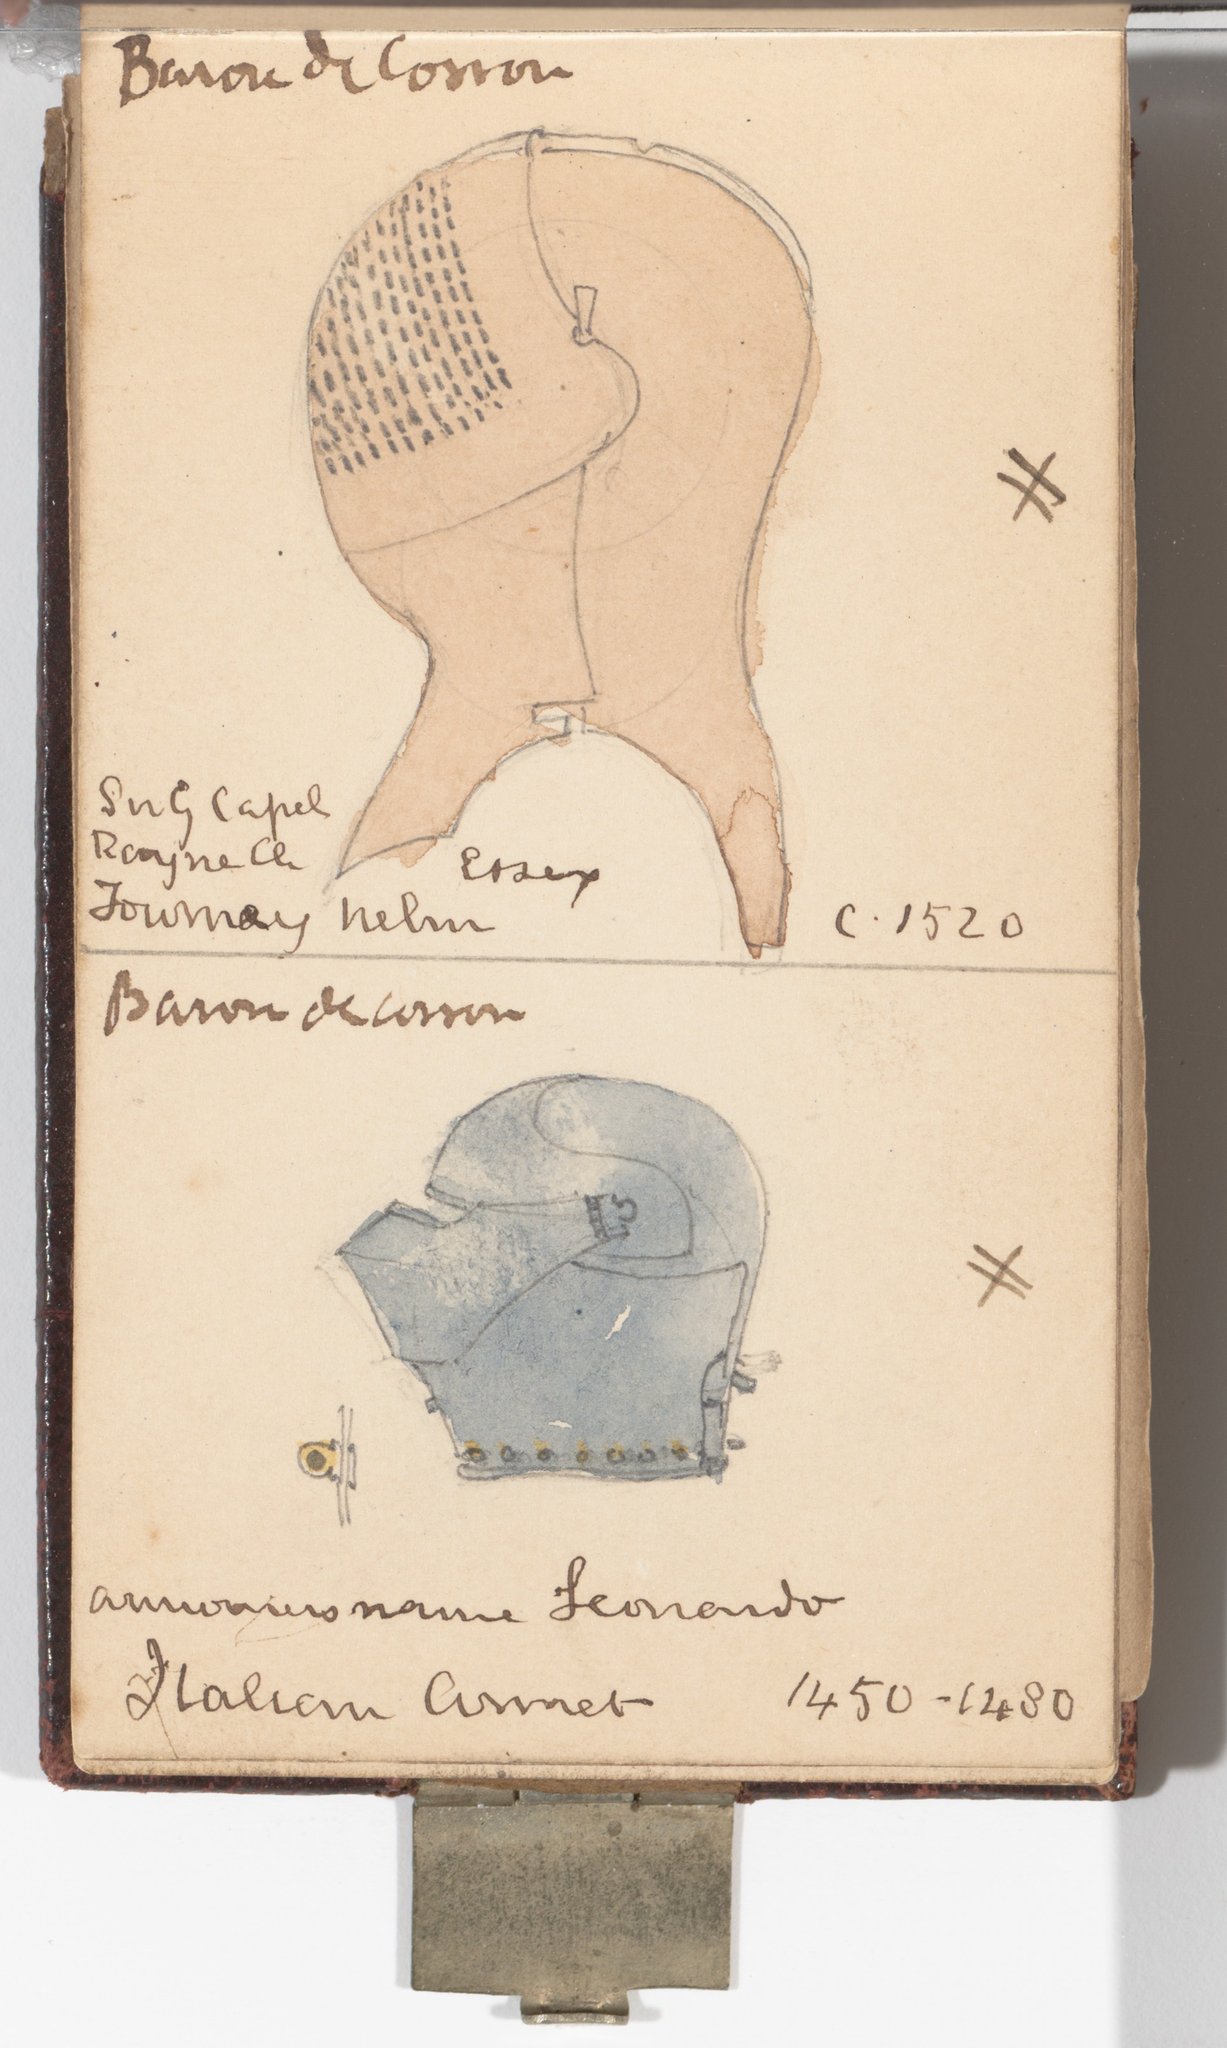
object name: sketchbook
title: Memorandum Book Showing Colored Sketches Mostly of European Helmets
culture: british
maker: william burges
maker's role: artist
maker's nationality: british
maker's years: 1827-1881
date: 1880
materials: leather, paper, silver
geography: england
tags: helmets